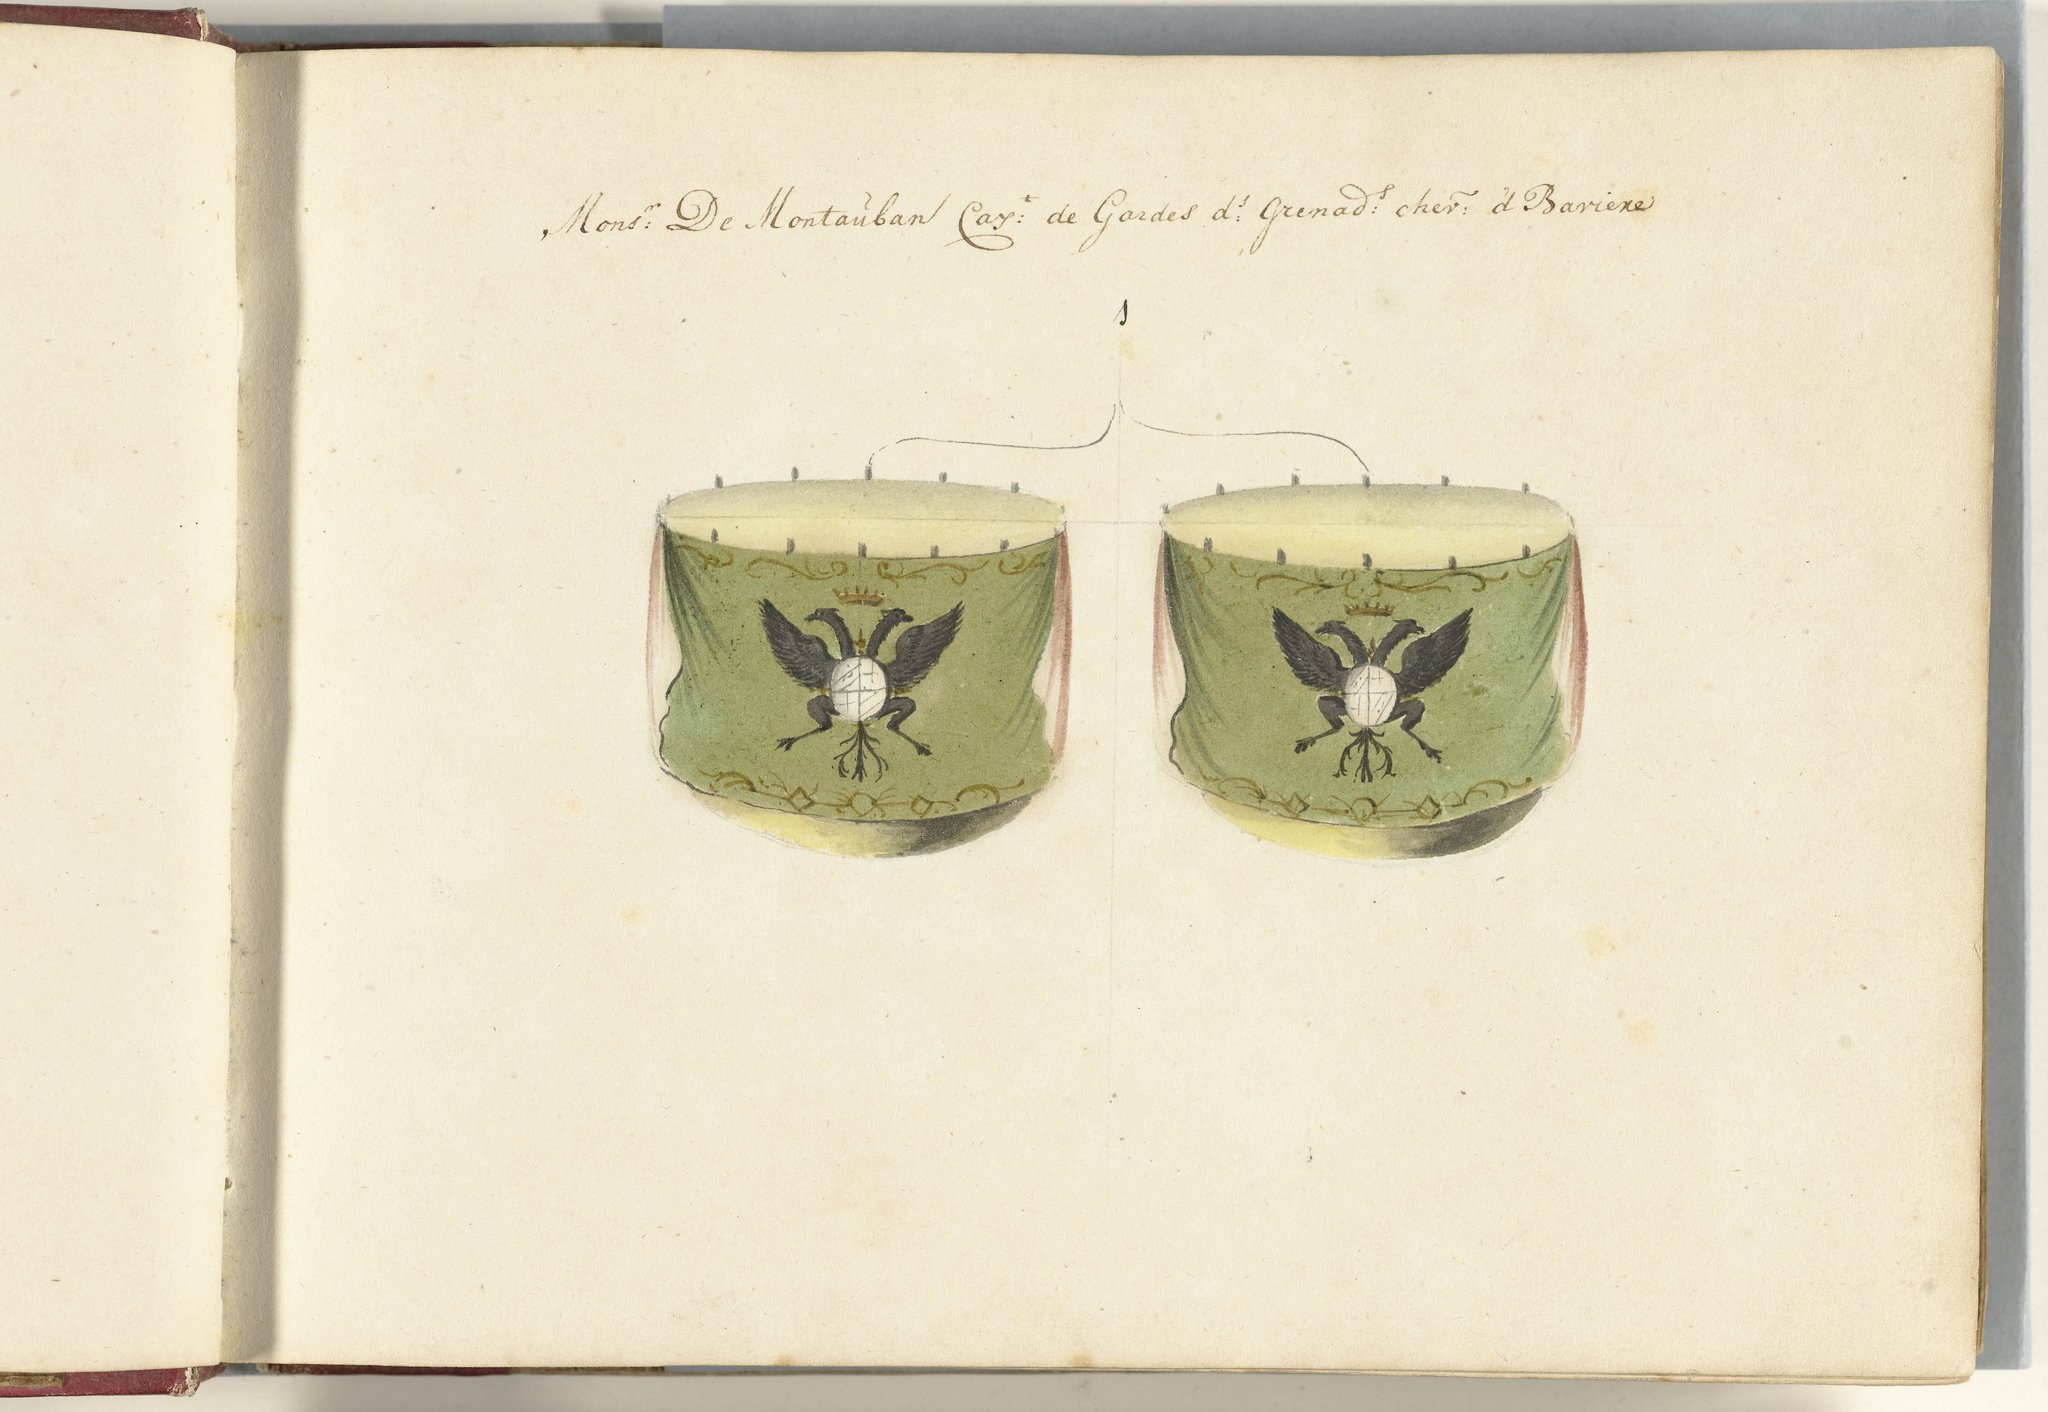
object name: drawing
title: Franse pauken veroverd in de slag bij Spierbach, 1703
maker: Anonymous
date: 1713-1720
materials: paper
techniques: drawing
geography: northern netherlands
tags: military music, drum (musical instrument)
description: Franse pauken veroverd in de slag bij Spierbach, 1703. In het boek met tekeningen van Franse vaandels, standaarden en pauken, veroverd tijdens de Spaanse Successieoorlog (1701-1713).